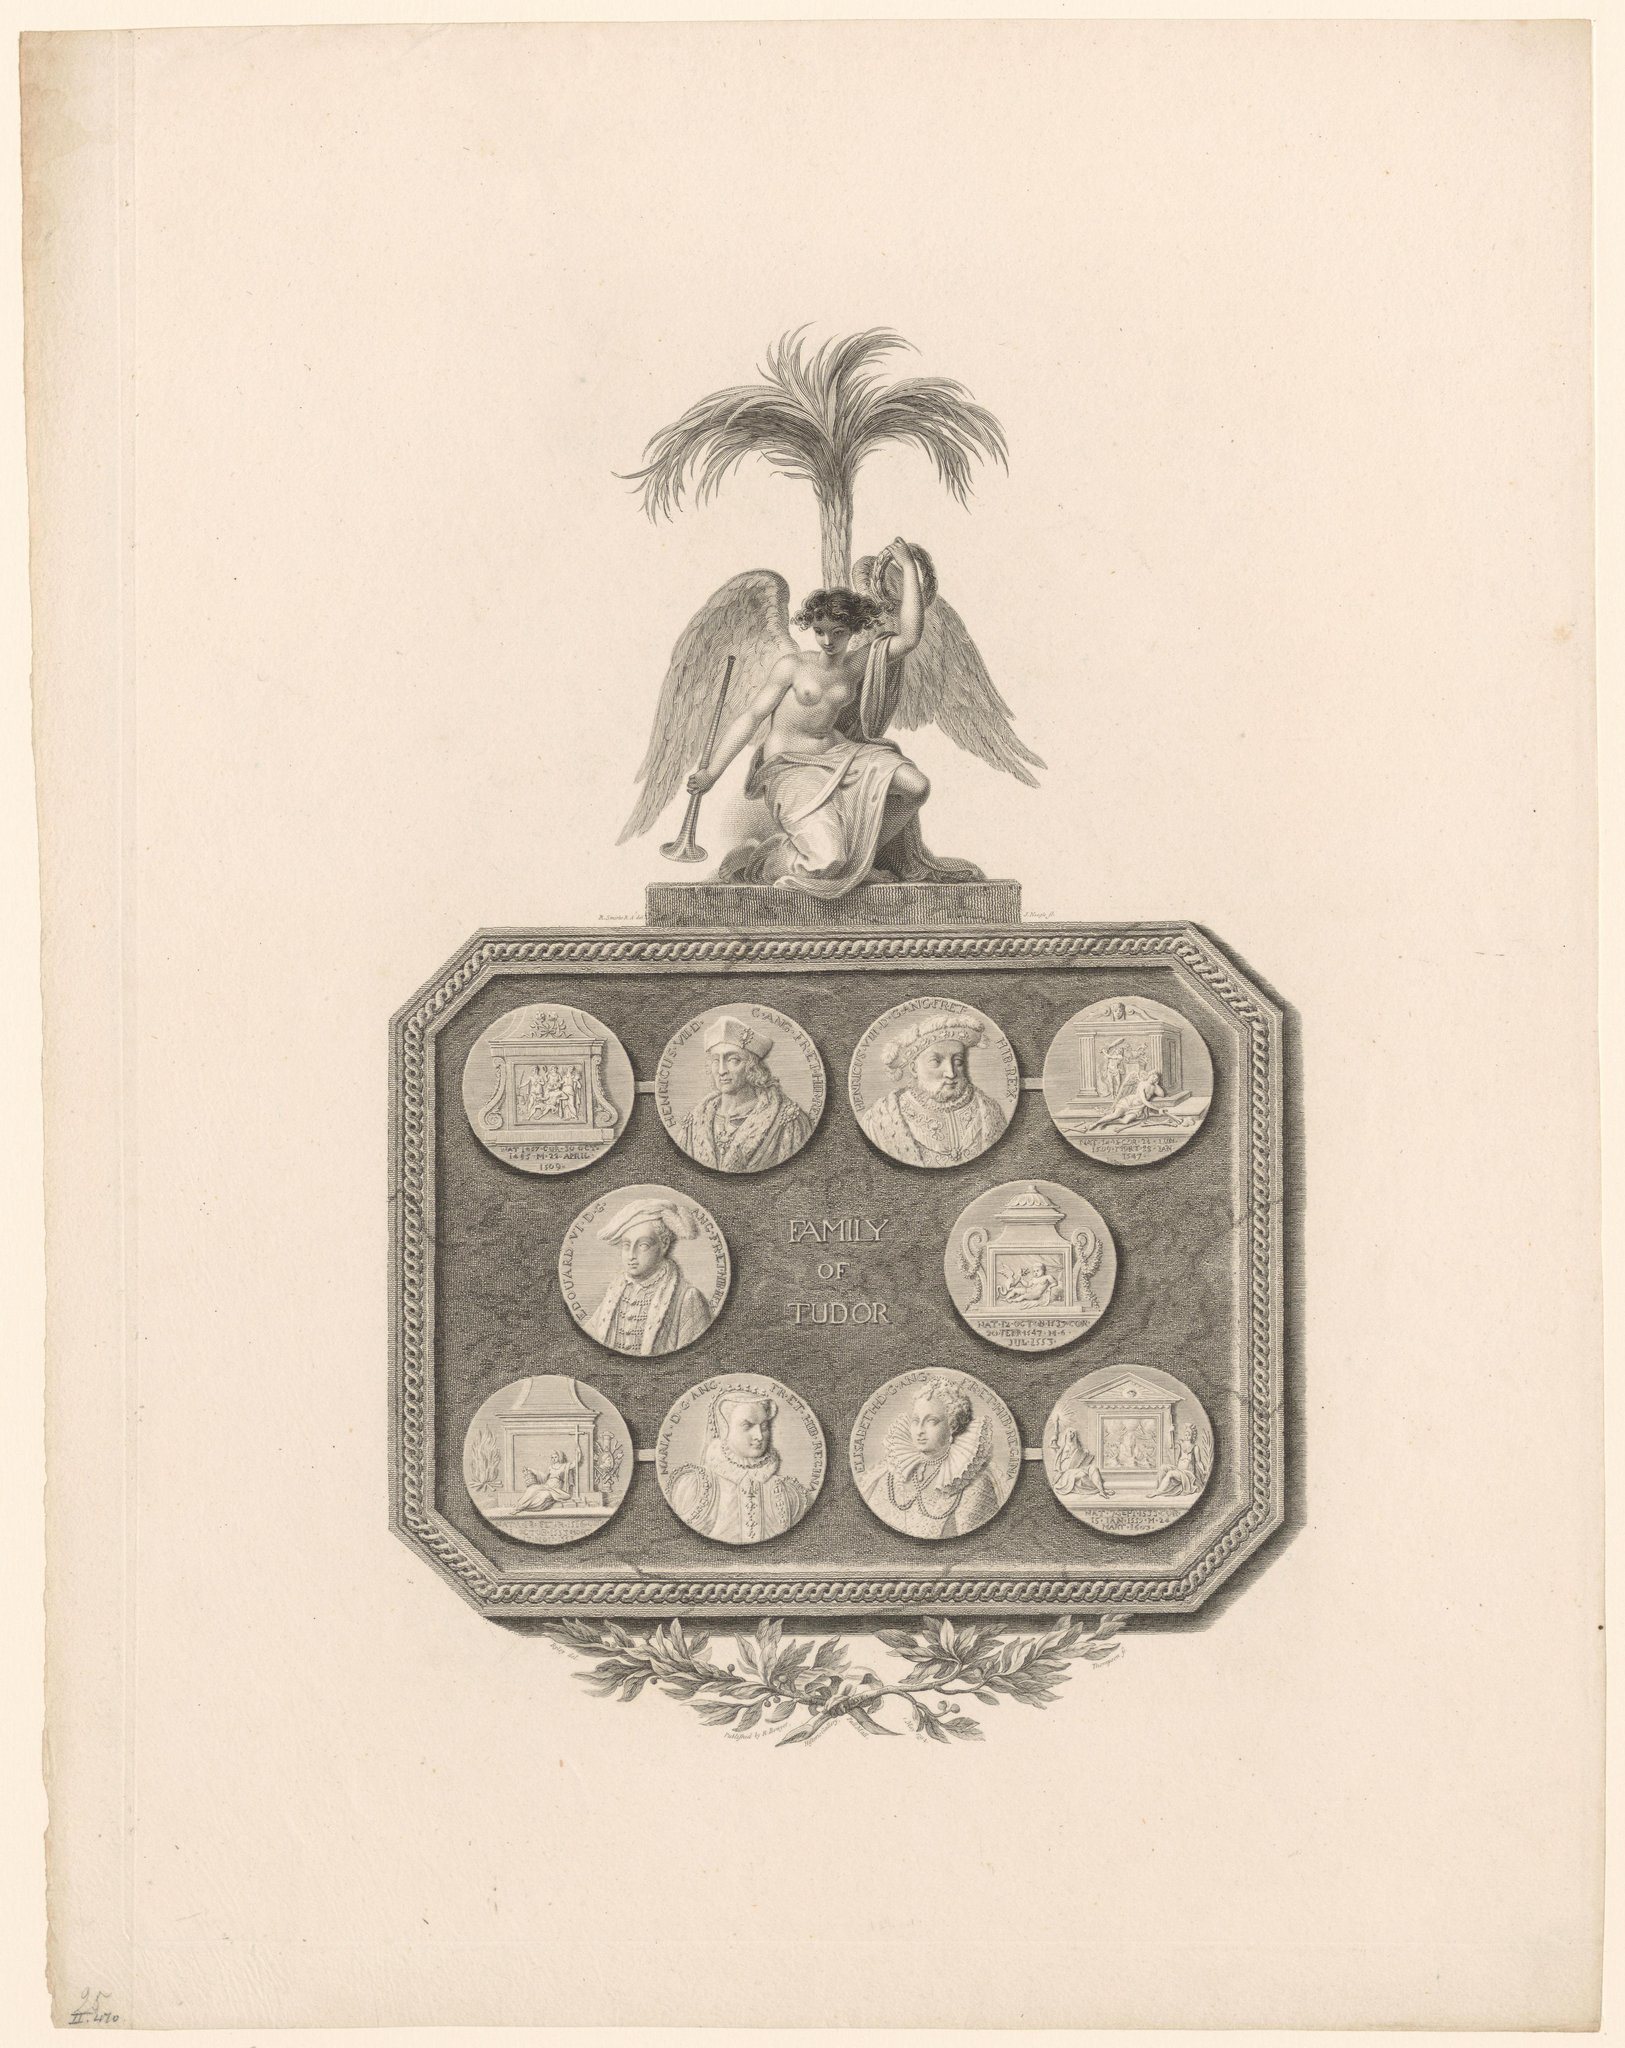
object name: print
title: Gedenkplaat met munten uit het Tudor-tijdperk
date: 1705-1794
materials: paper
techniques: etching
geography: london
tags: london, historical persons, coin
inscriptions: collector's mark: Lugt 2228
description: De prenten uit deze serie zijn naar schilderijen uit Bowyer's Historic Gallery. Deze schilderijen en tekeningen illustreerden de gebeurtenissen uit David Hume's History of England. De prenten zijn daarom mogelijk gebruikt als illustratie in deze boeken.